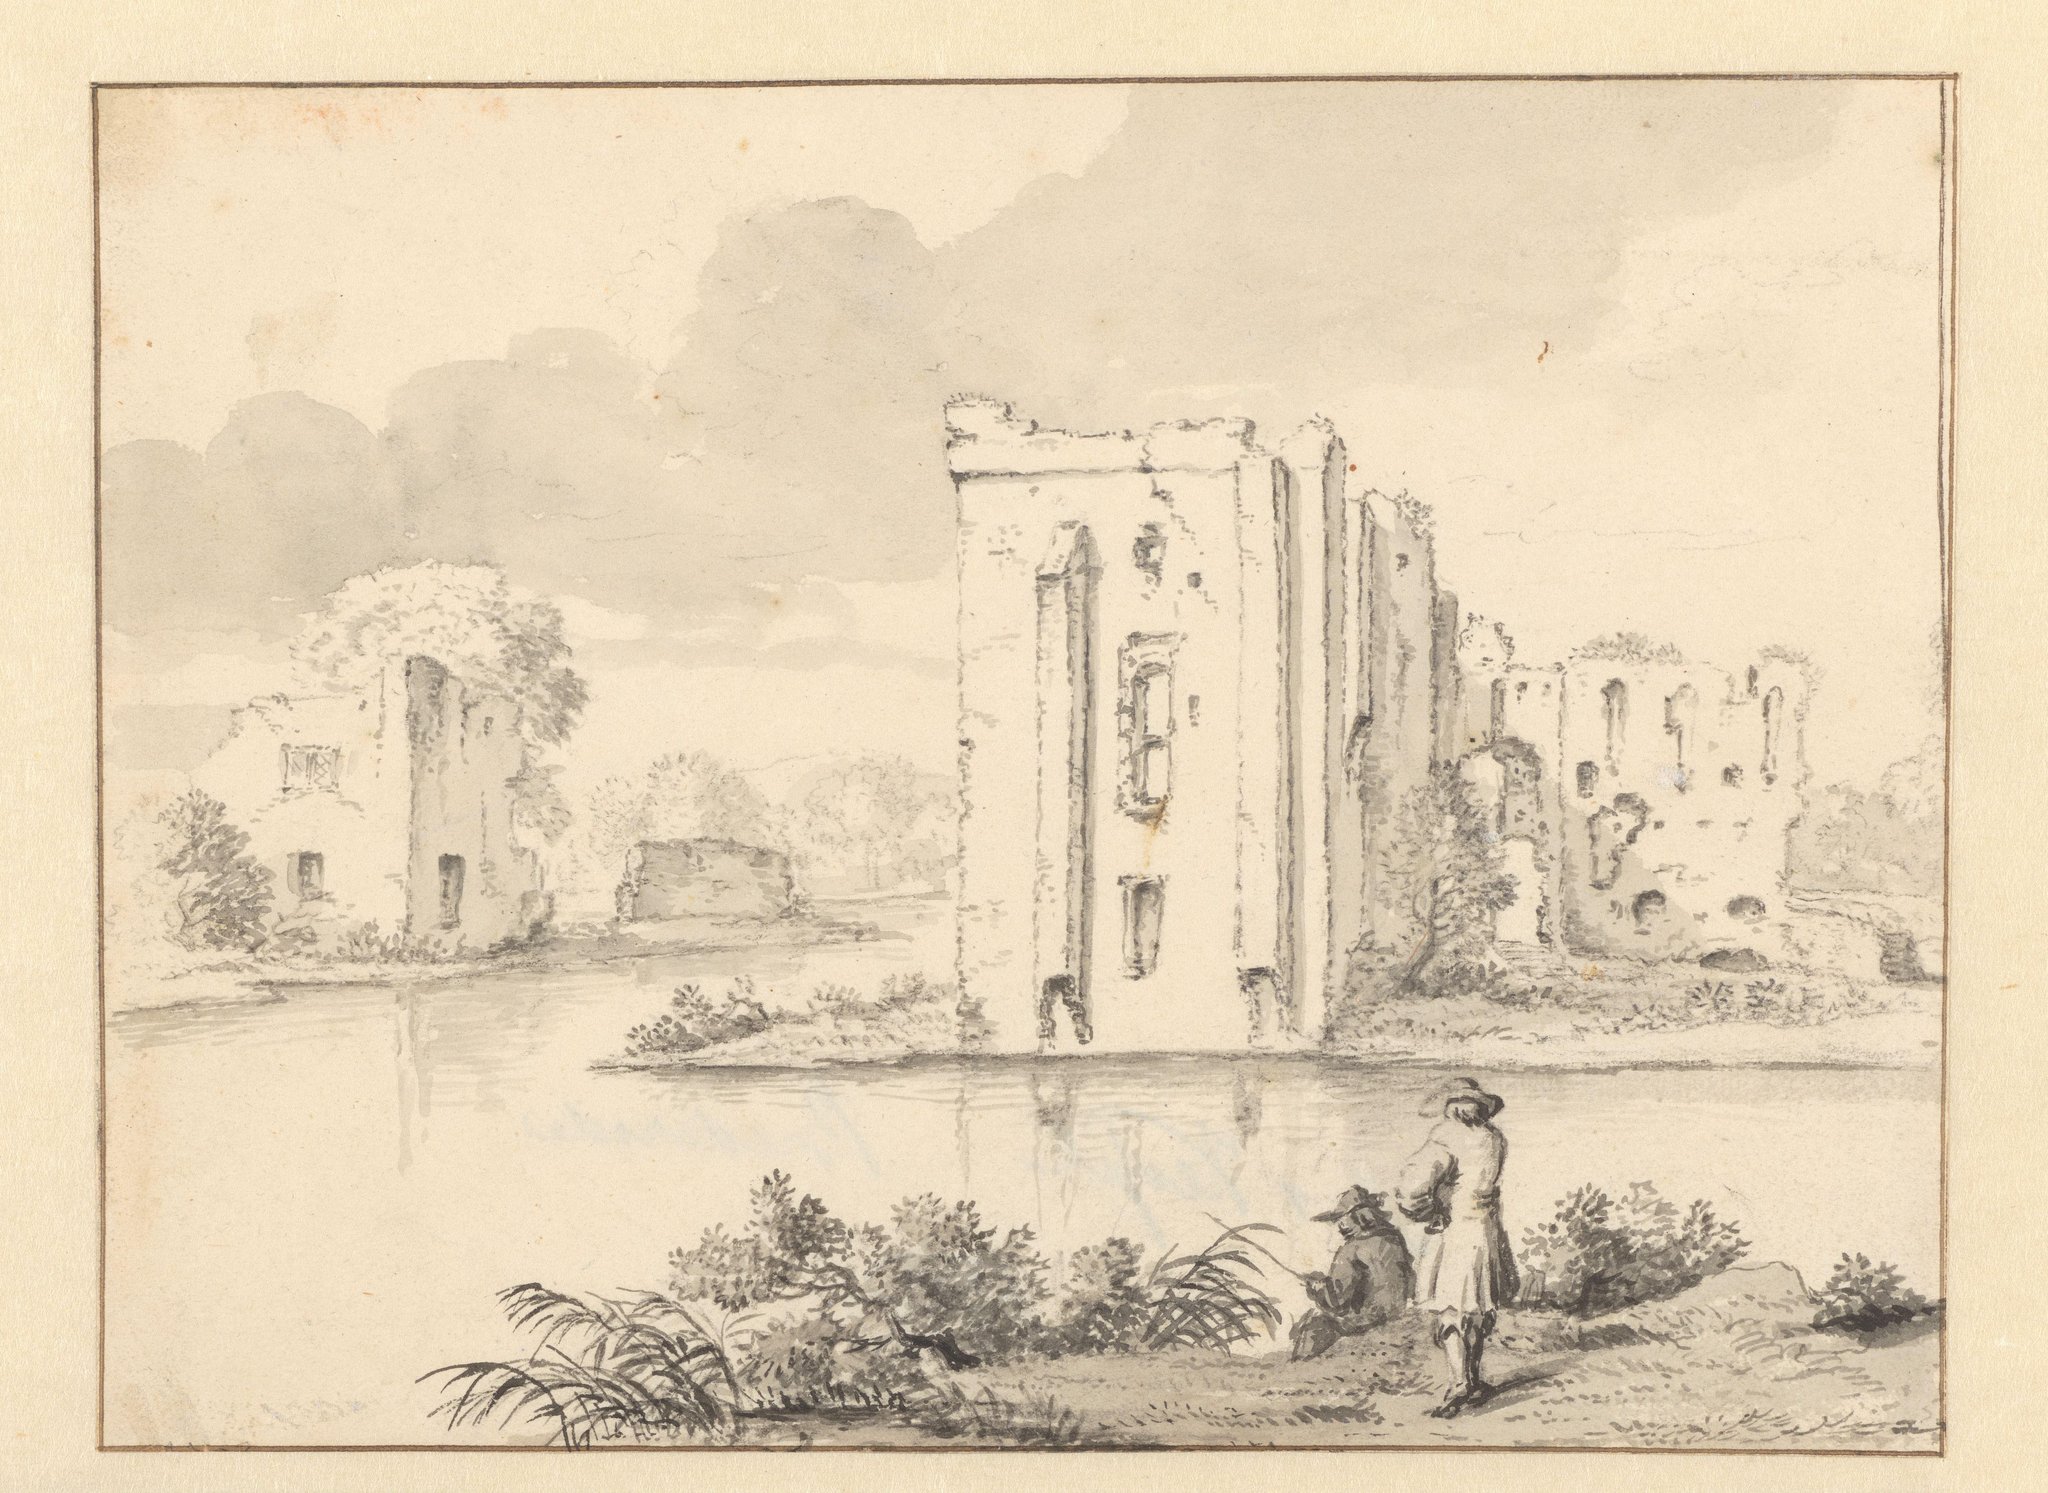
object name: drawing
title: View of the Ruins of Brederode Castle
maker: jan van kessel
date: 1660-1665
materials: chalk, paper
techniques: brush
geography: santpoort-zuid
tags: landscape with ruins